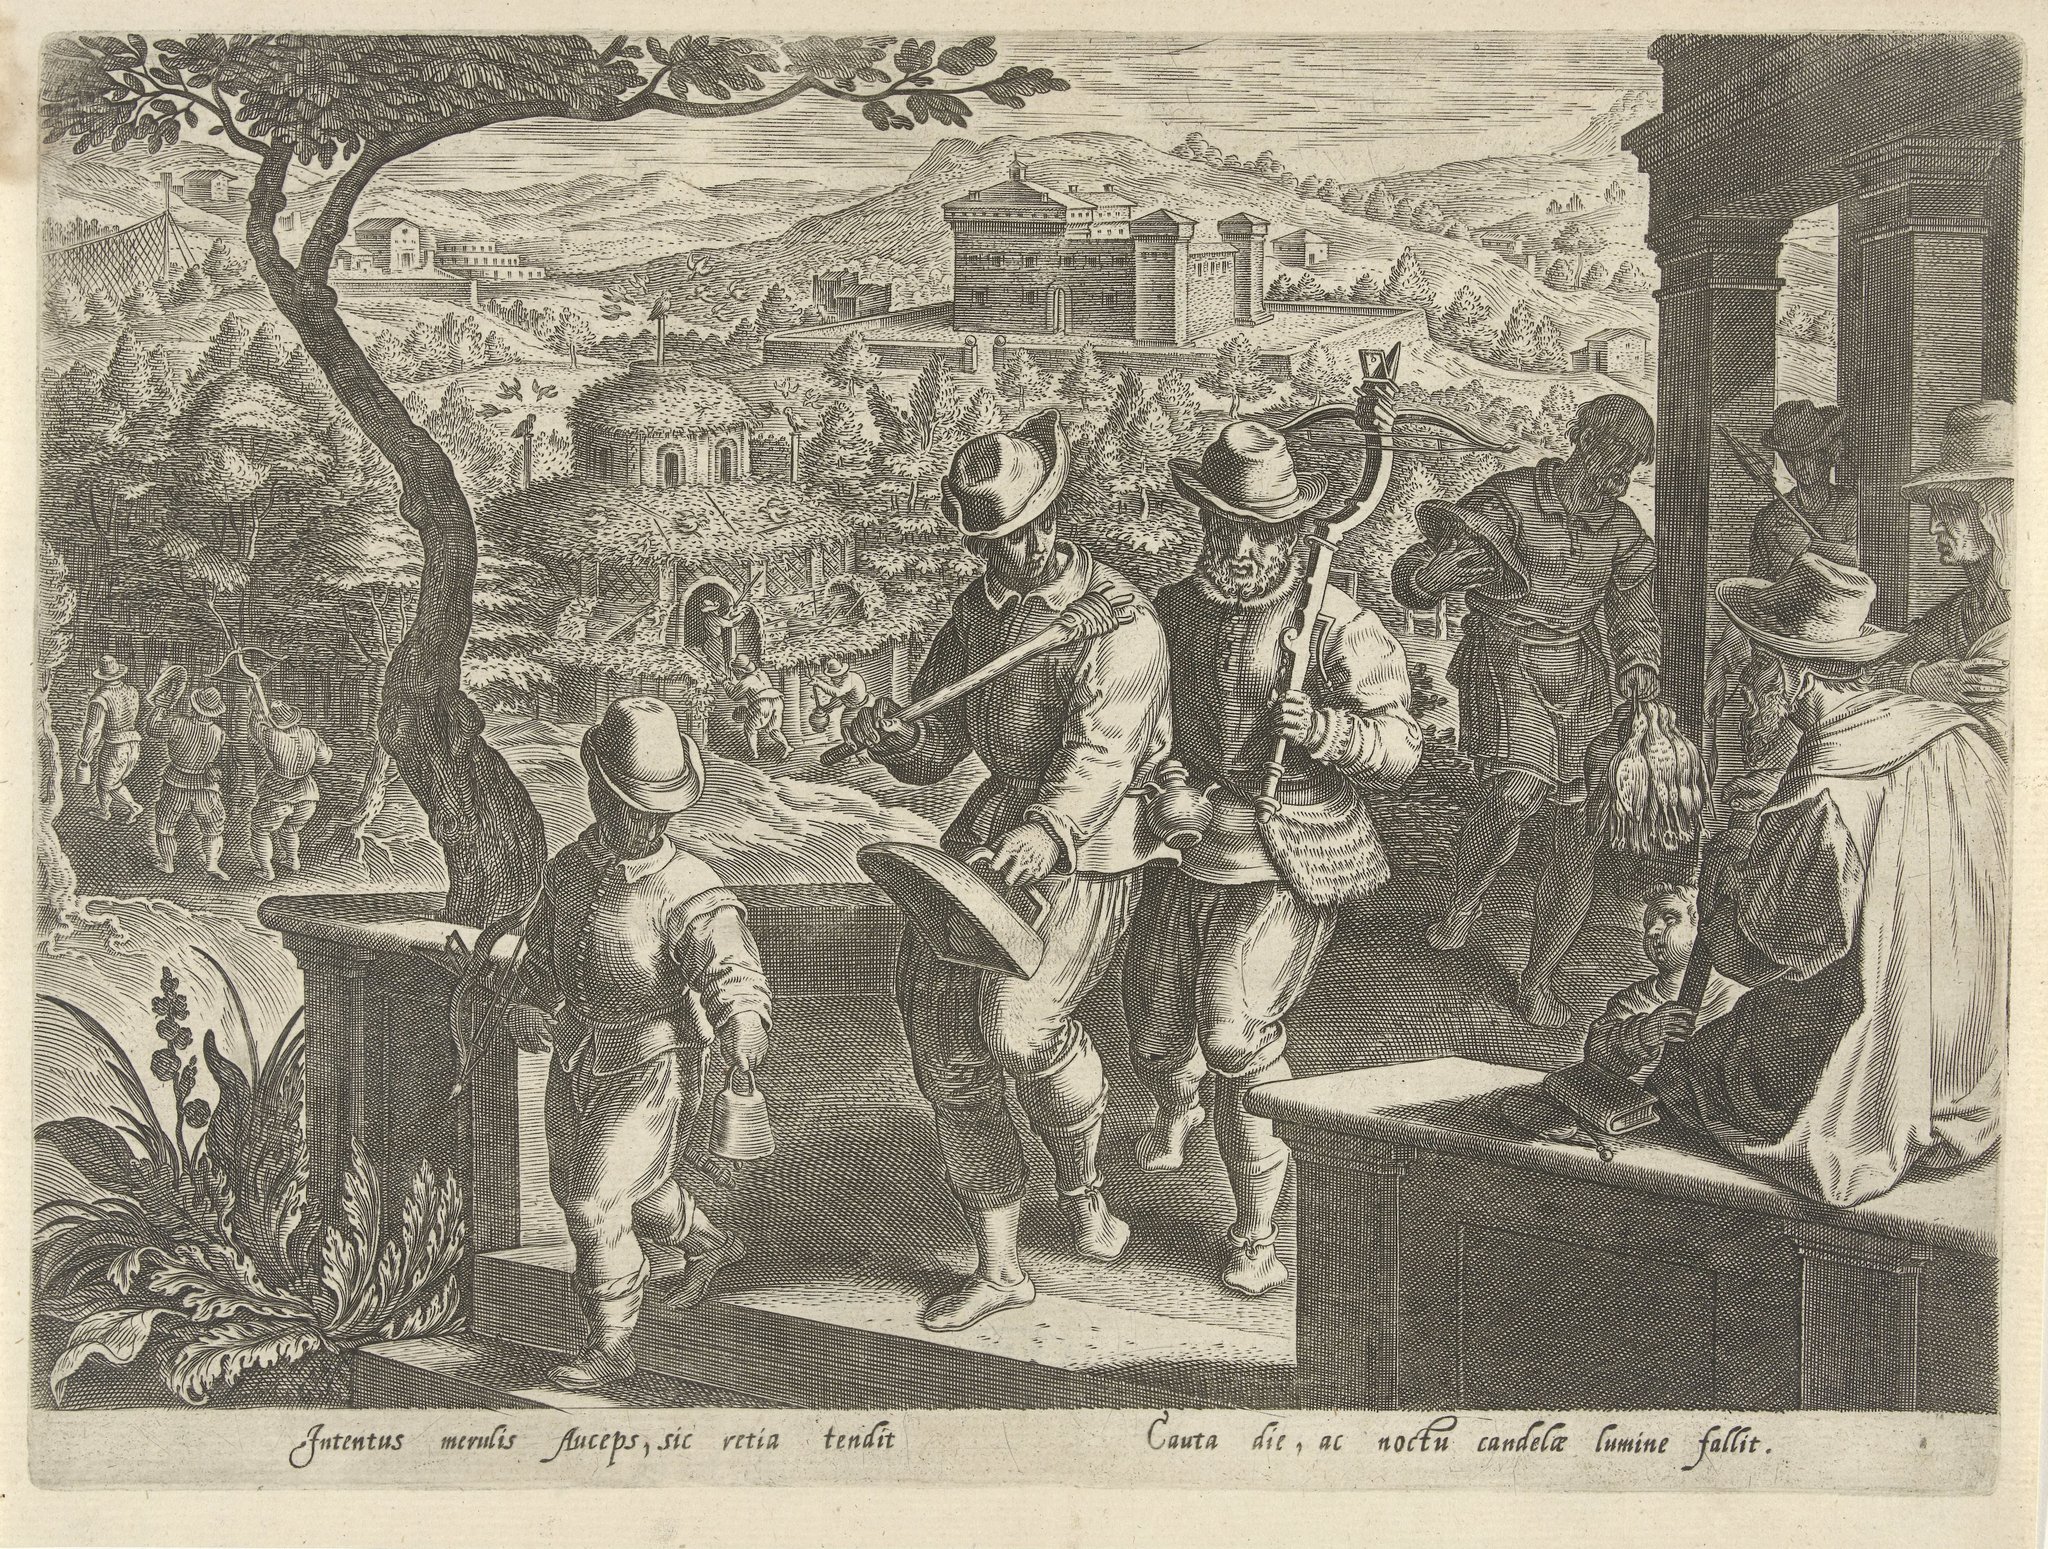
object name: print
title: Jacht op merels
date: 1578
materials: paper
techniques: engraving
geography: florence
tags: song-birds: blackbird, bird hunting (+ hunting weapons, equipment, outfit)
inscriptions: collector's mark: Lugt 2228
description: Op de voorgrond gaan drie jagers op weg om merels te vangen. In hun handen voorwerpen die daarbij helpen: een kruisboog, een bel, een lantaarn en een knuppel. In de achtergrond vangen de drie merels. De prent heeft een Latijns onderschrift en maakt deel uit van een 43-delige serie over de jacht.